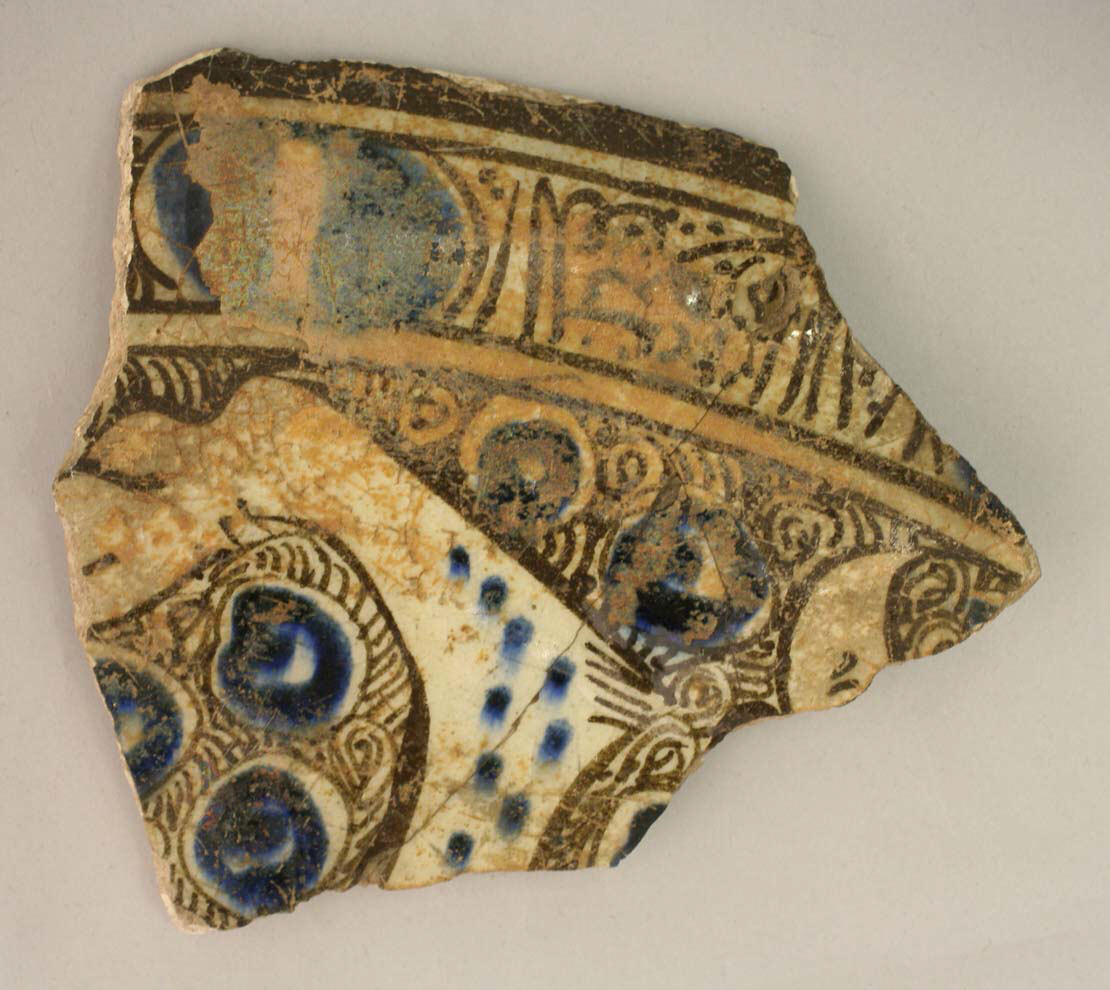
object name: fragment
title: Ceramic Fragment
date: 1301-1400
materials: stonepaste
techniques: painting, underglaze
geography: syria